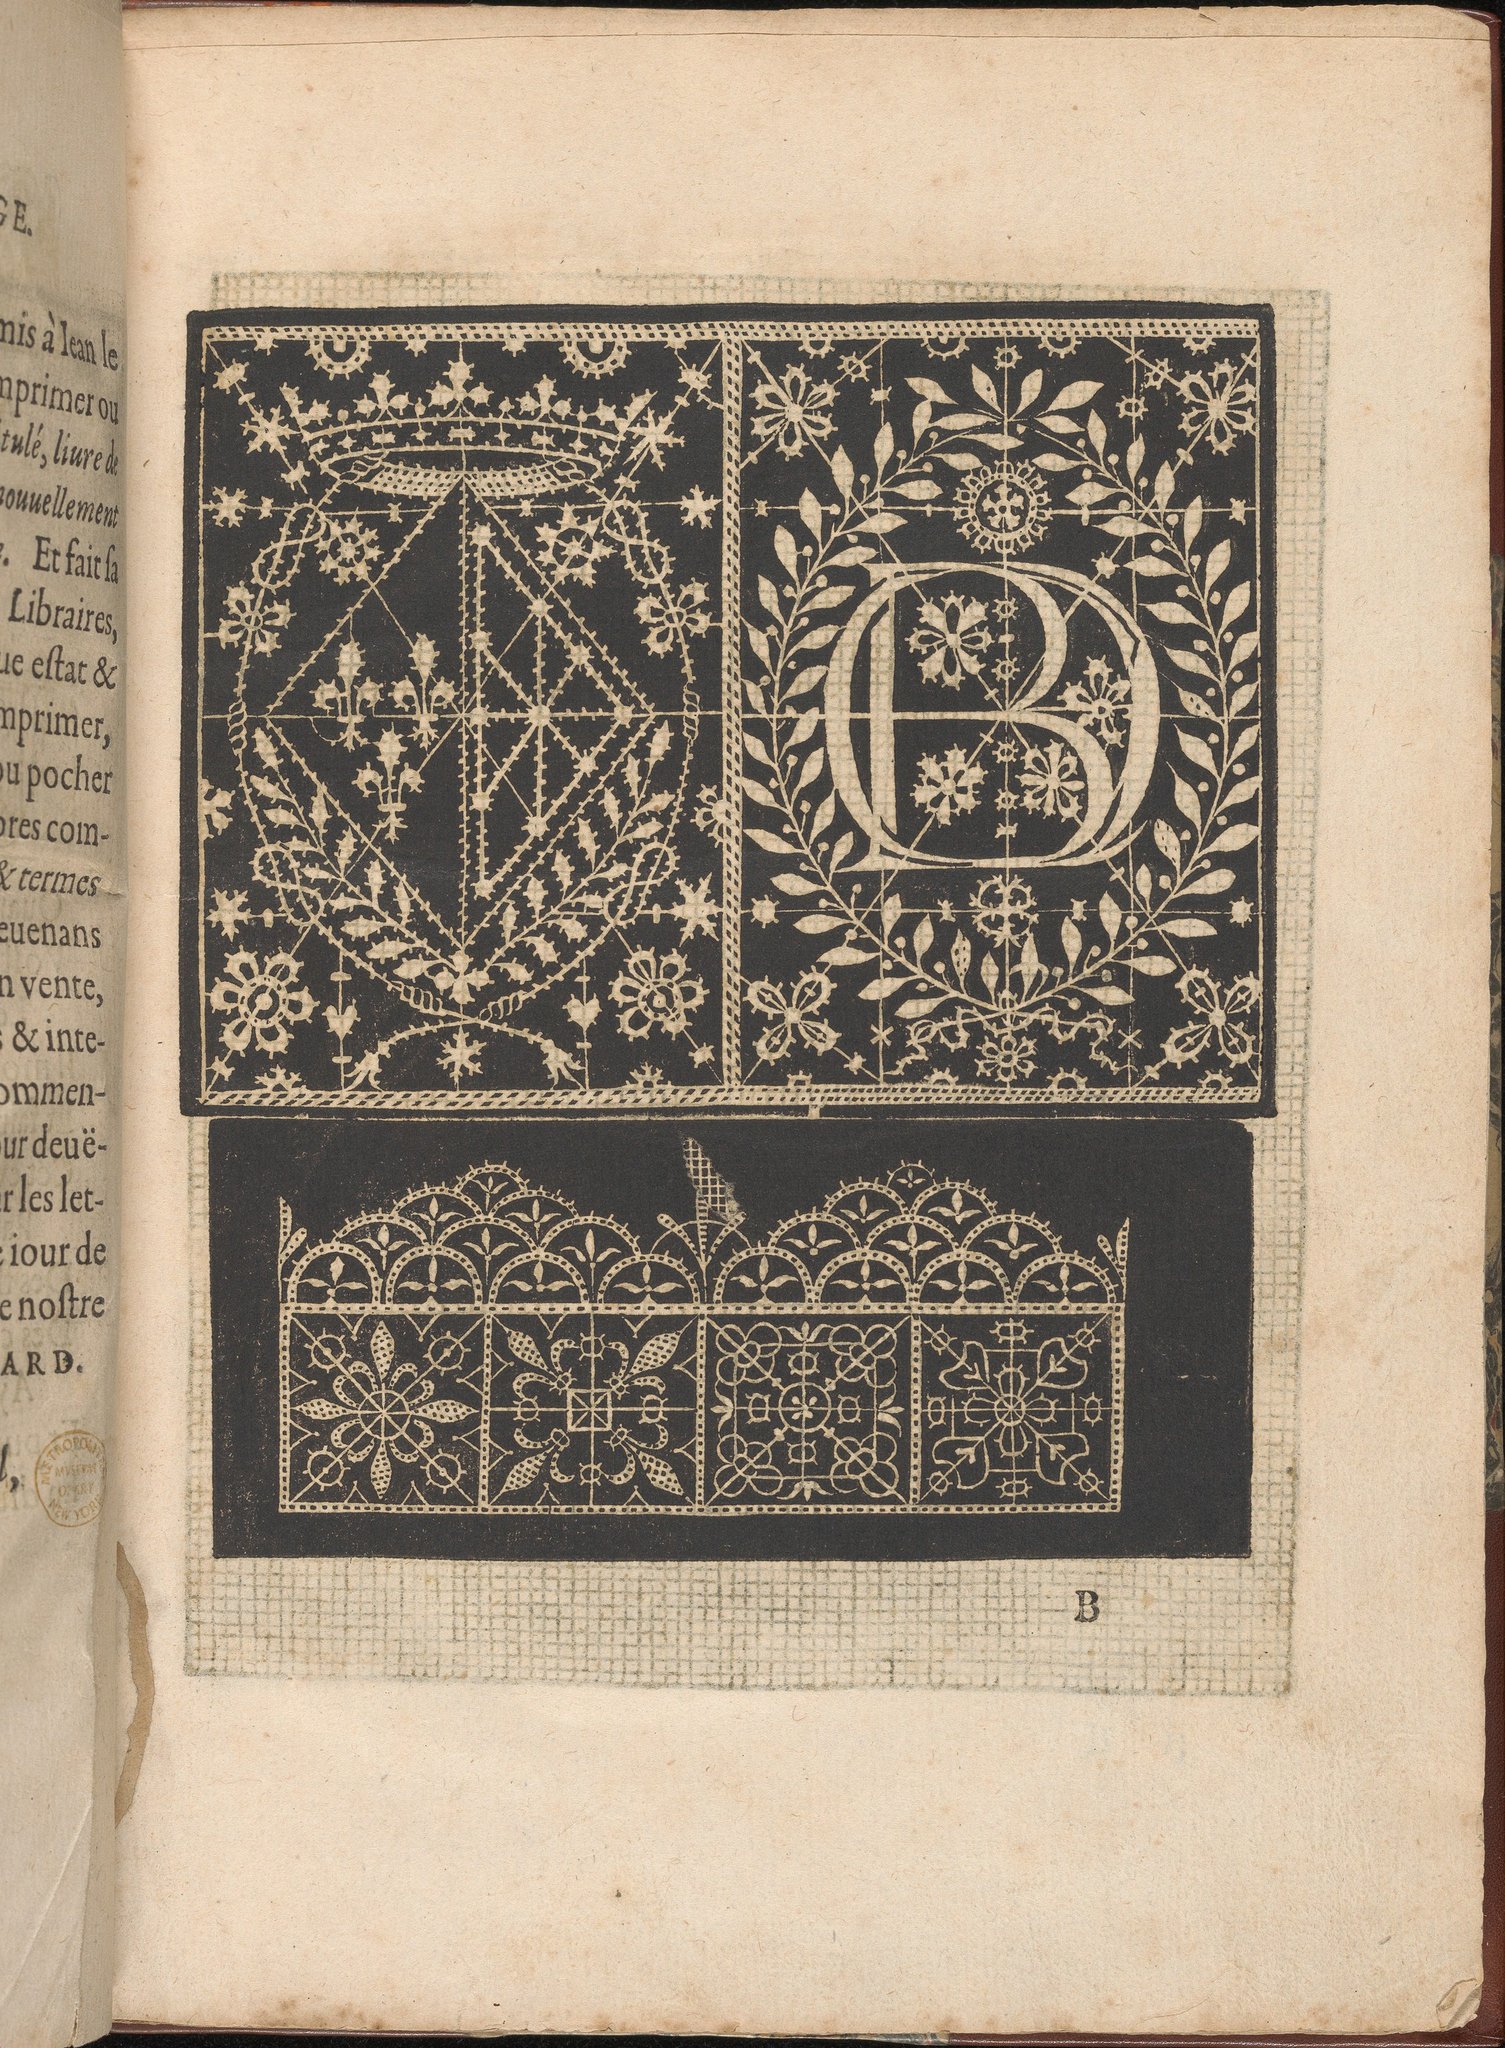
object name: book print ornament architecture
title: Les Secondes Oeuvres, et Subtiles Inventions De Lingerie du Seigneur Federic de Vinciolo Venitien, page 5 (recto)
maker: federico de vinciolo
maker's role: designer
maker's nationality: italian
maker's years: 1582-1599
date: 1603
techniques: woodcut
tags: ornament